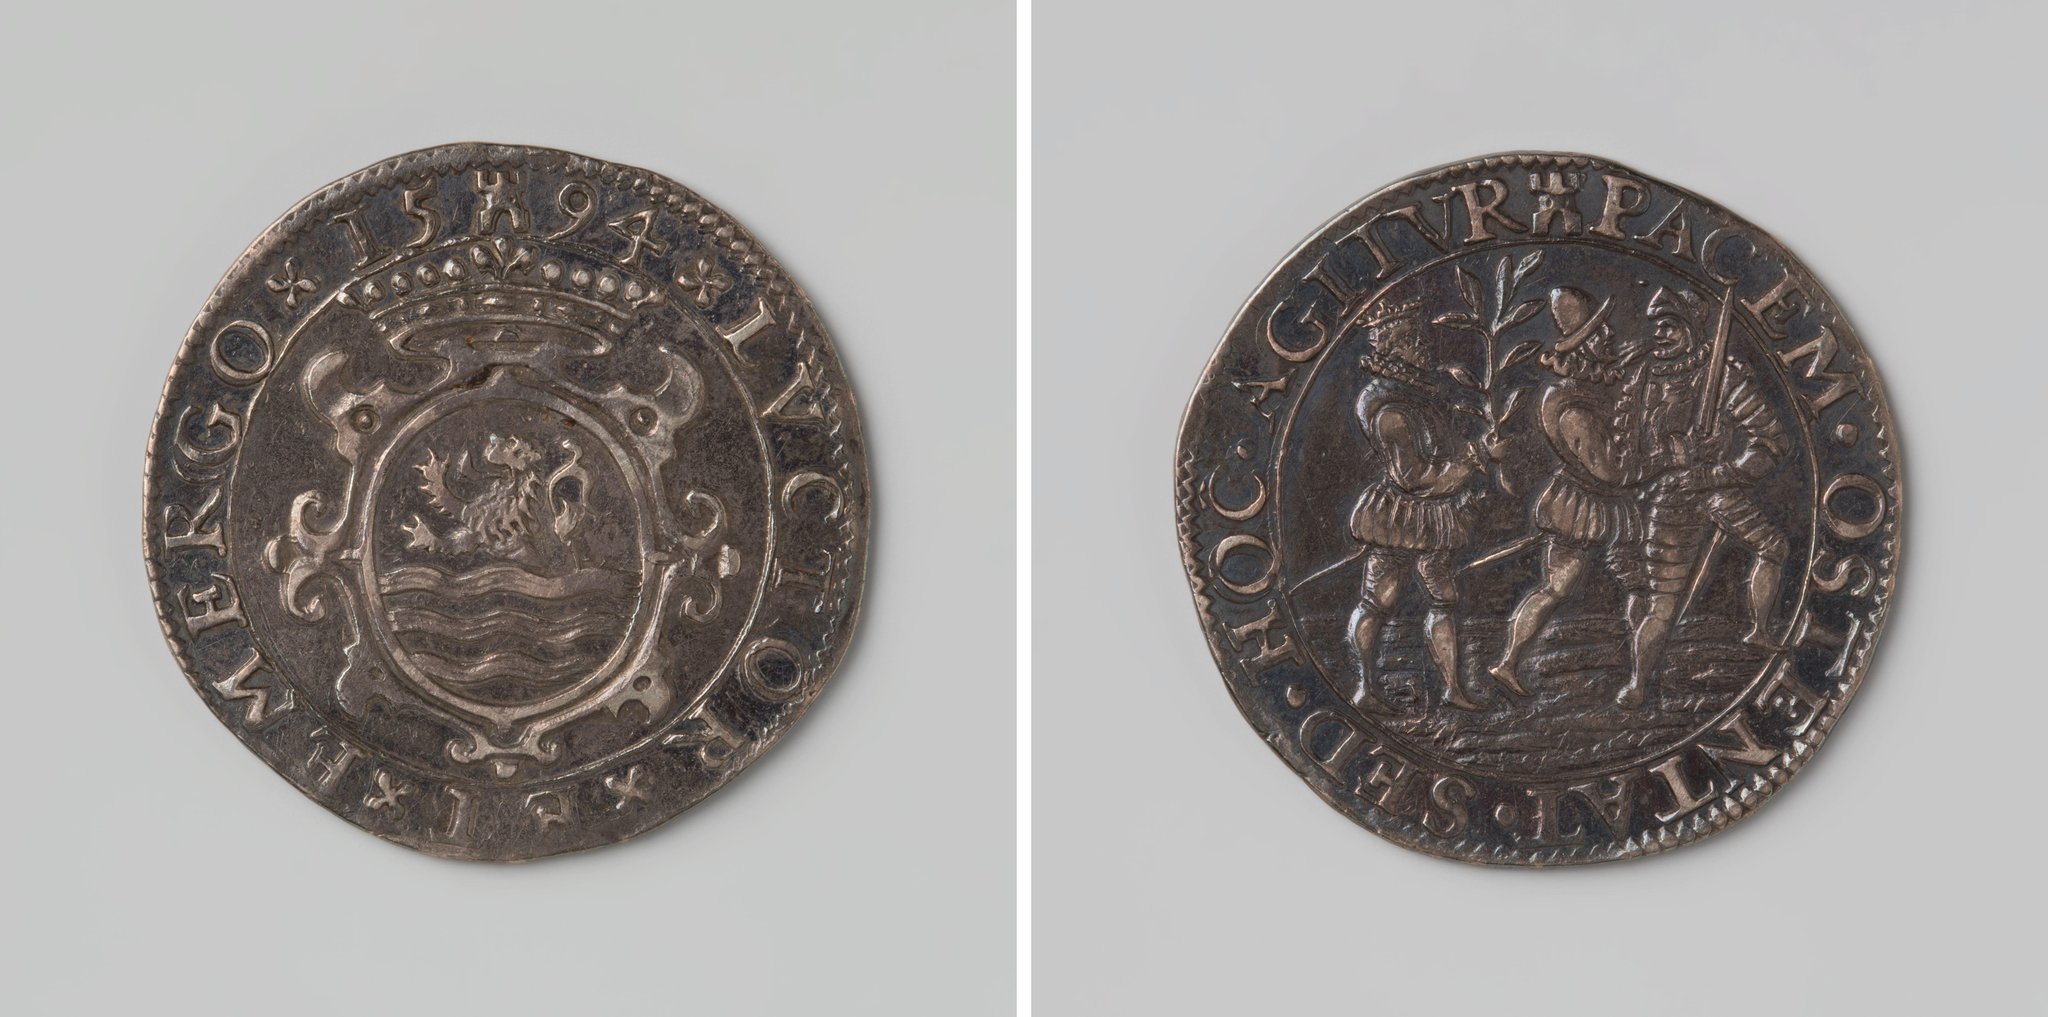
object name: jeton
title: Afwijzing door de Staten-Generaal van de vredesvoorstellen van Ernst, aartshertog van Oostenrijk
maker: Anonymous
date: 1594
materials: silver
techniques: striking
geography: middelburg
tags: philip ii of spain, vienna, zeeland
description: Zilveren penning. Voorzijde: gekroond wapenschild in cartouche binnen omschrift. Keerzijde: Filips II biedt een Nederlander de vredestak aan, terwijl een Spaanse soldaat hem probeert te ontwapenen binnen omschrift